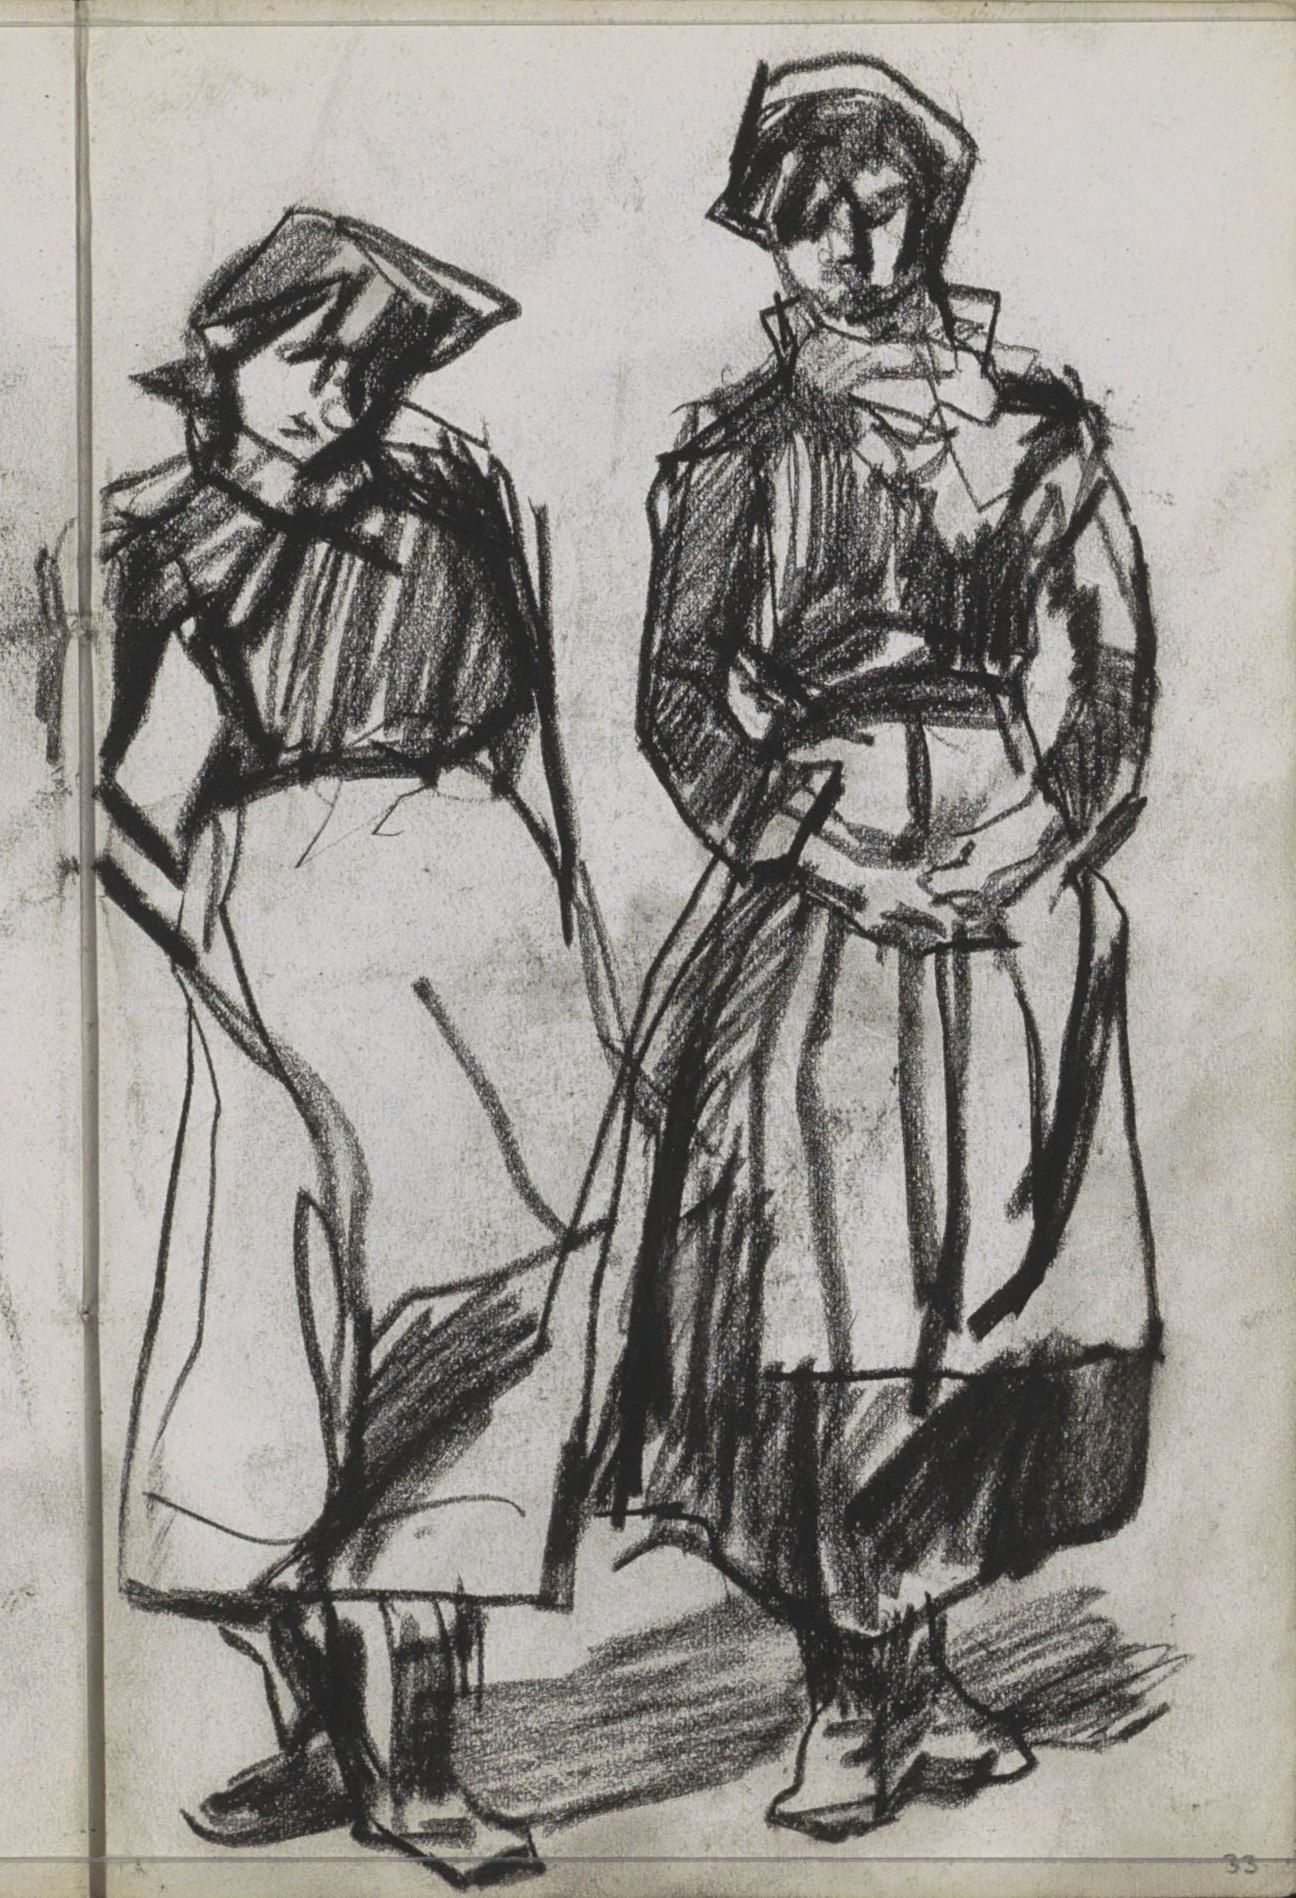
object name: sketchbook leaf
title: Twee staande jonge vrouwen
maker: isaac israels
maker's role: draughtsman, painter, print maker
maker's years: 1865-1934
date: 1875-1934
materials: chalk, paper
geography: amsterdam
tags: adolescent, young woman, maiden (+ standing)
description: Pagina 33 uit schetsboek XXIX met 44 pagina's.